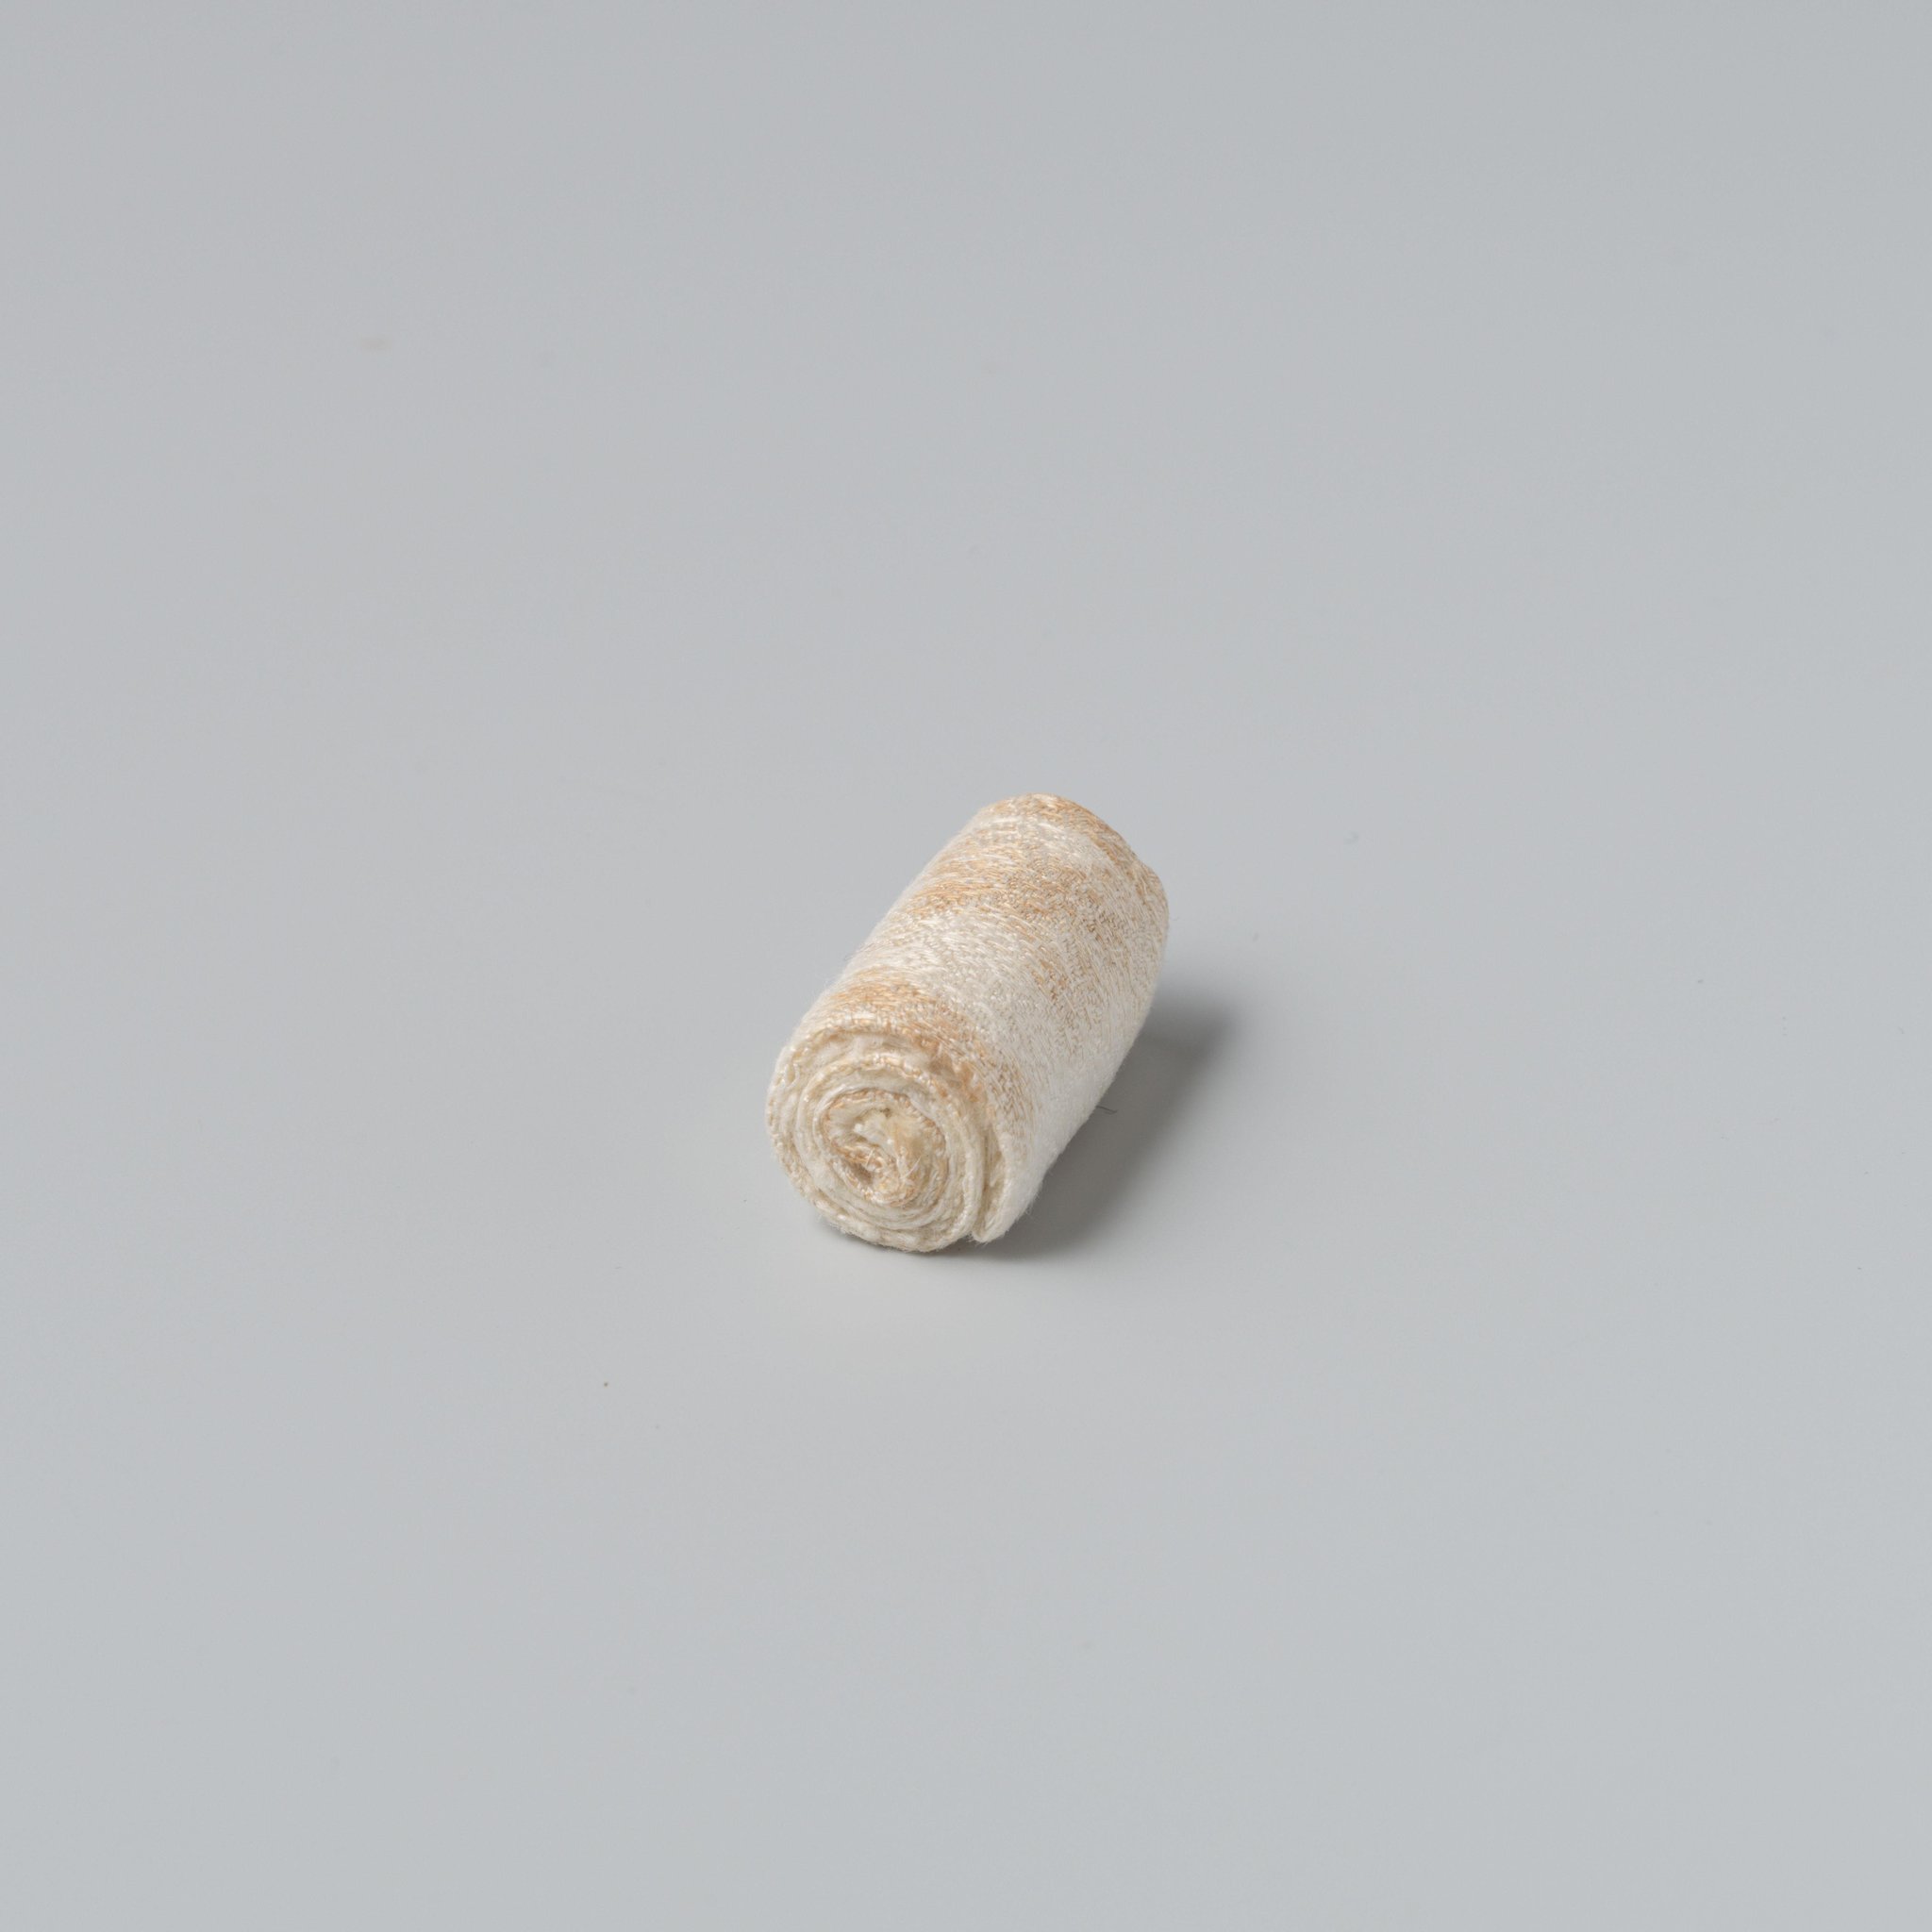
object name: miniature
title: Rol linnen, damastweefsel met pellenpatroon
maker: Anonymous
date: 1600-1699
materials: linen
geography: netherlands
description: Rol linnen, damastweefsel met pellenpatroon.